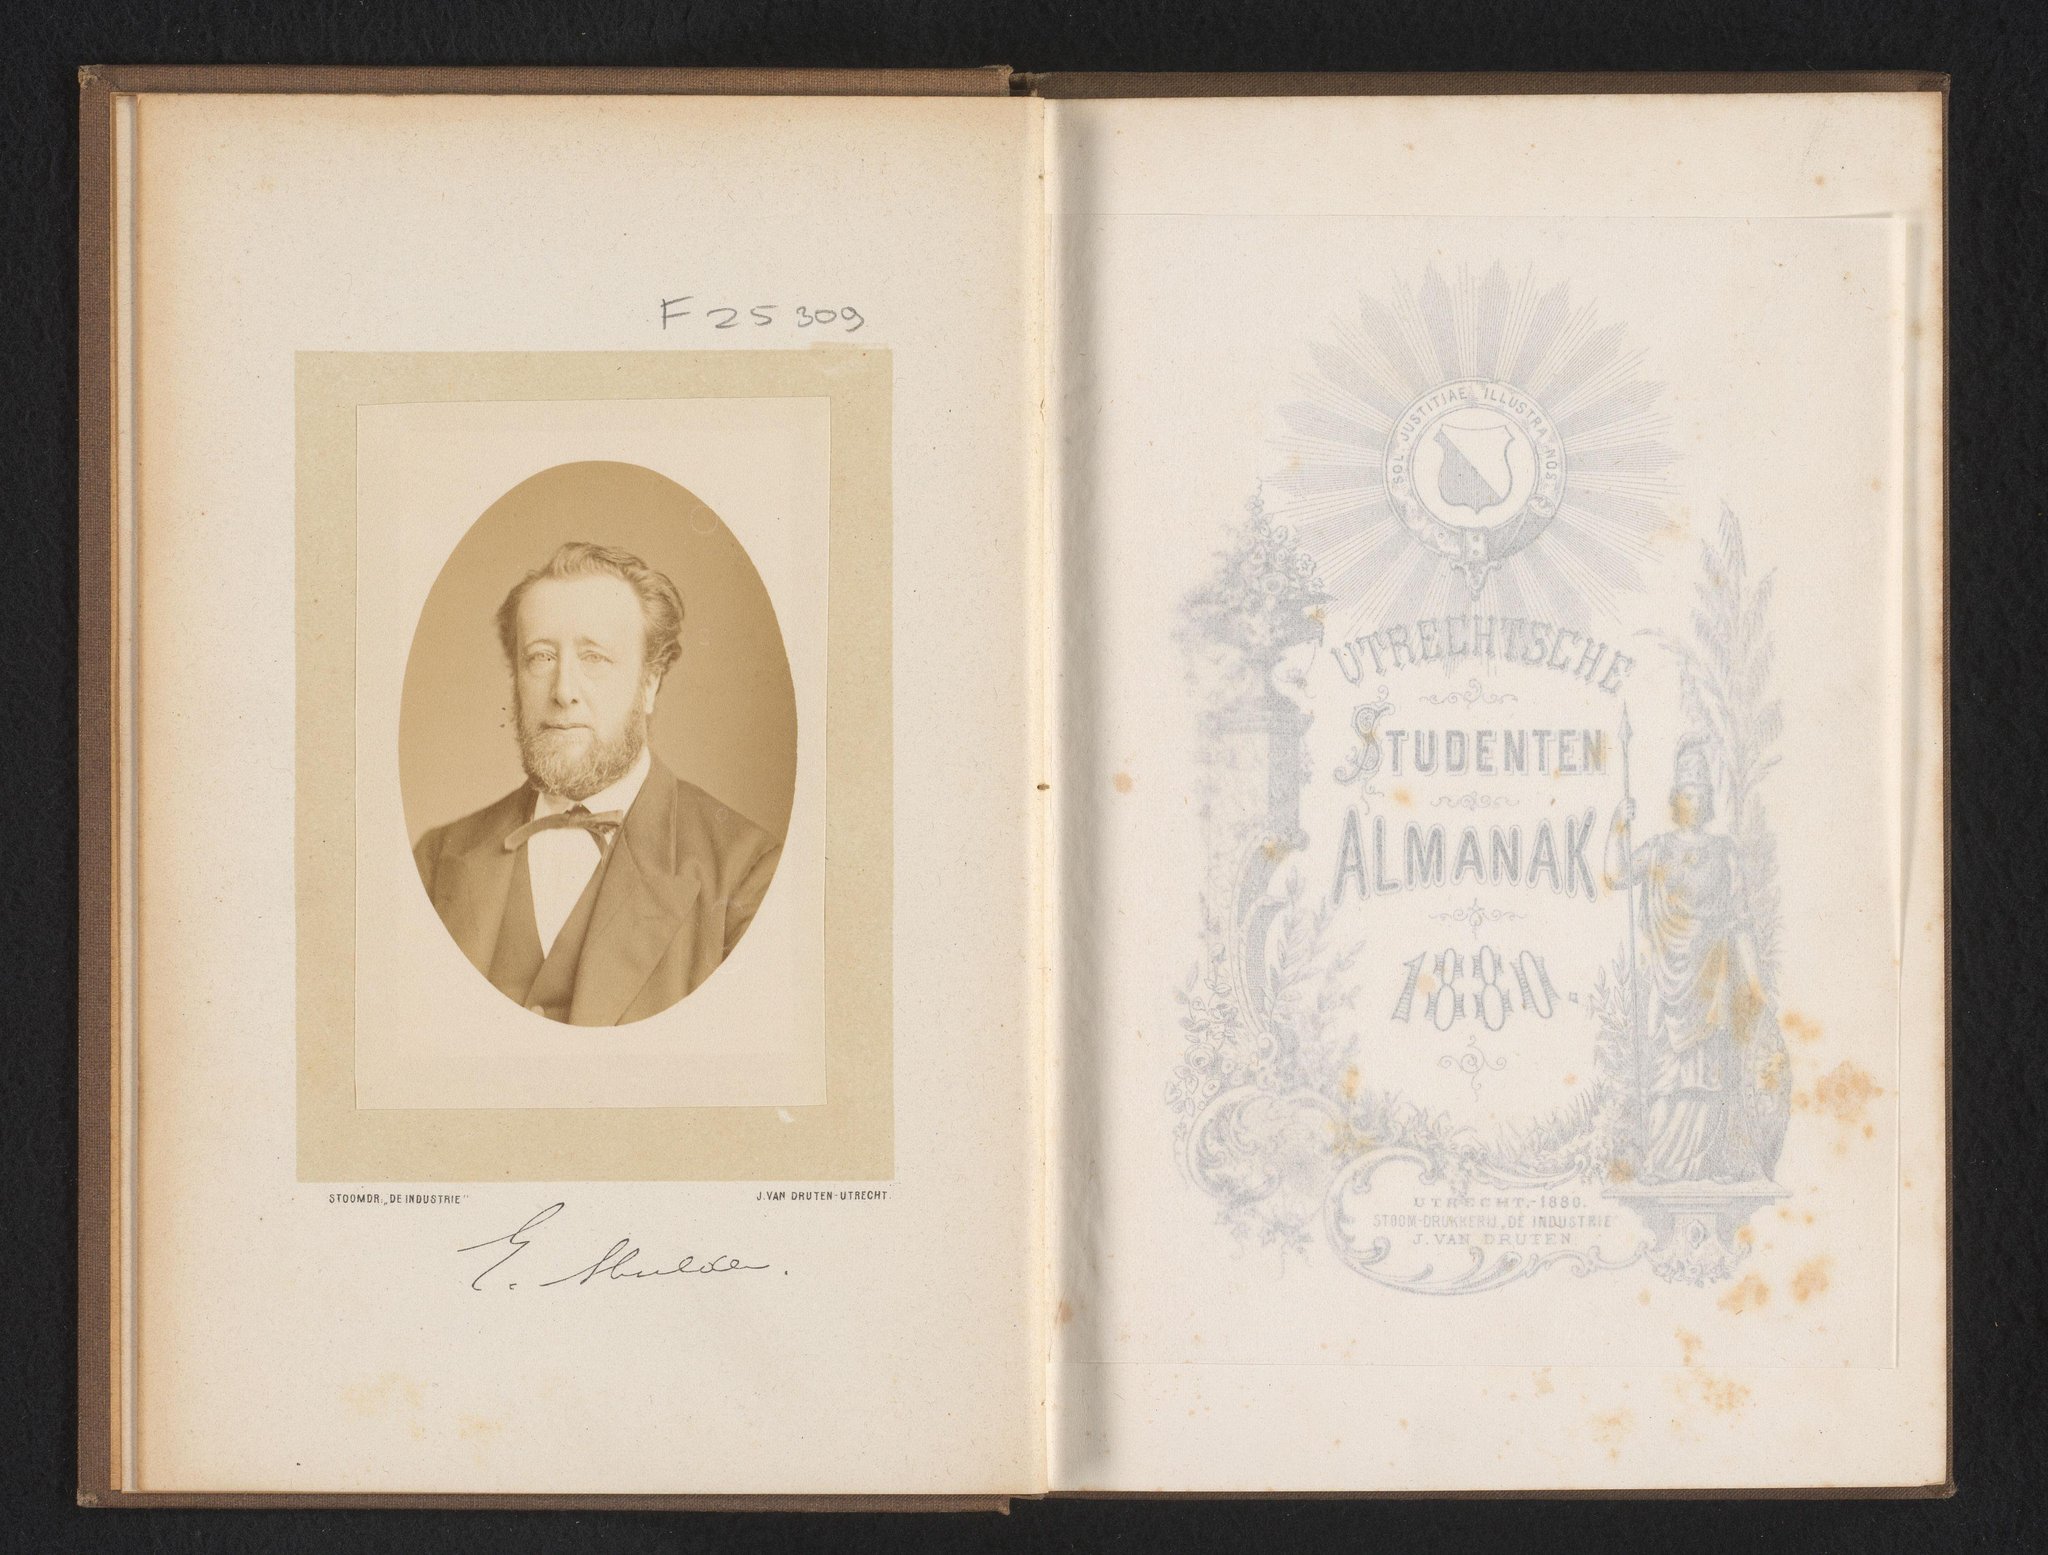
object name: photograph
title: Portret van Eduard Mulder, hoogleraar wis- en natuurkunde en rector magnificus van de Universiteit Utrecht 1879-1880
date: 1878-1879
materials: paper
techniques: albumen print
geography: utrecht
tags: rotterdam, utrecht, historical persons, professor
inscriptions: signature: ‘E. Mulder’